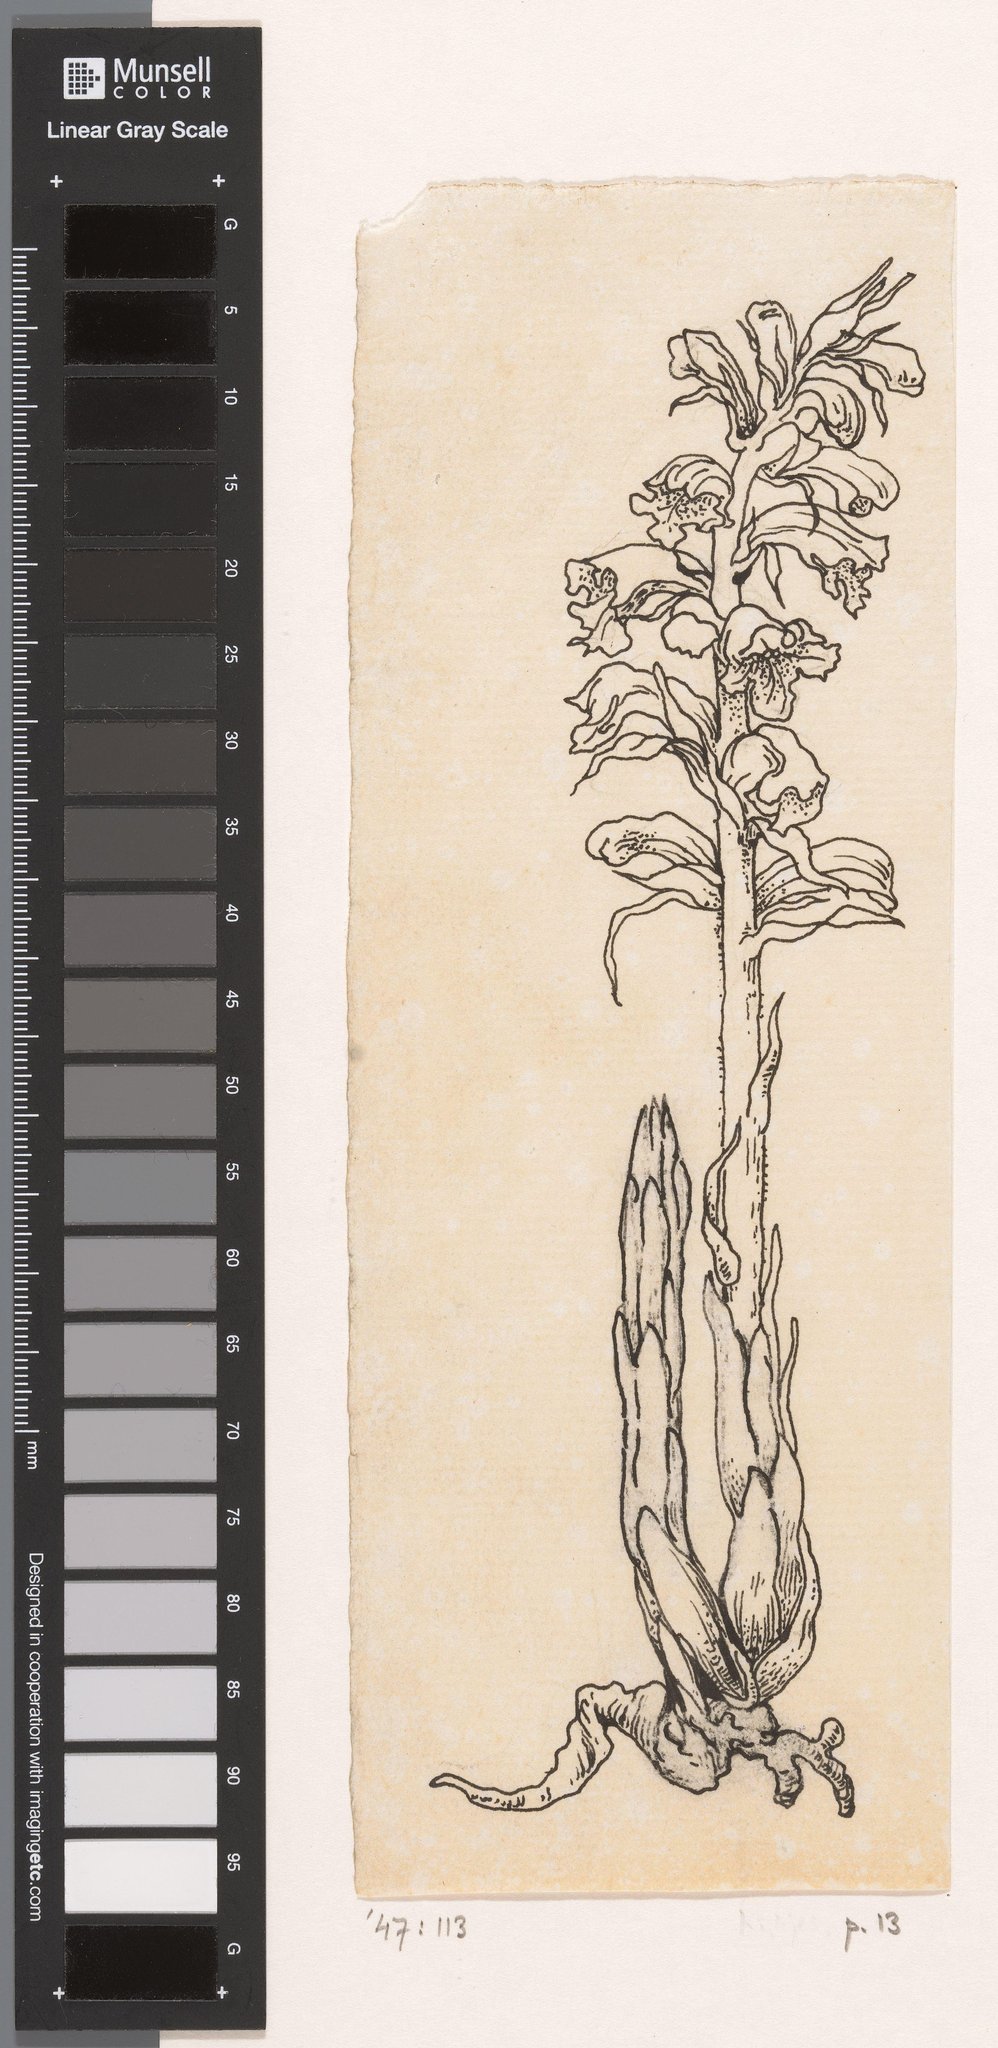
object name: boekillustratie ontwerp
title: Bremraap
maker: willem wenckebach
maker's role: designer, draughtsman, painter, print maker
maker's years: 1860-1937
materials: ink, paper, pencil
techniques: pen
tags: plants (in general)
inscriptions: collector's mark: Lugt 2228a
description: Ontwerp voor: Knappert, Emilie C. Kijkjes in de plantenwereld. Loman & Funke: Amsterdam, 1893.